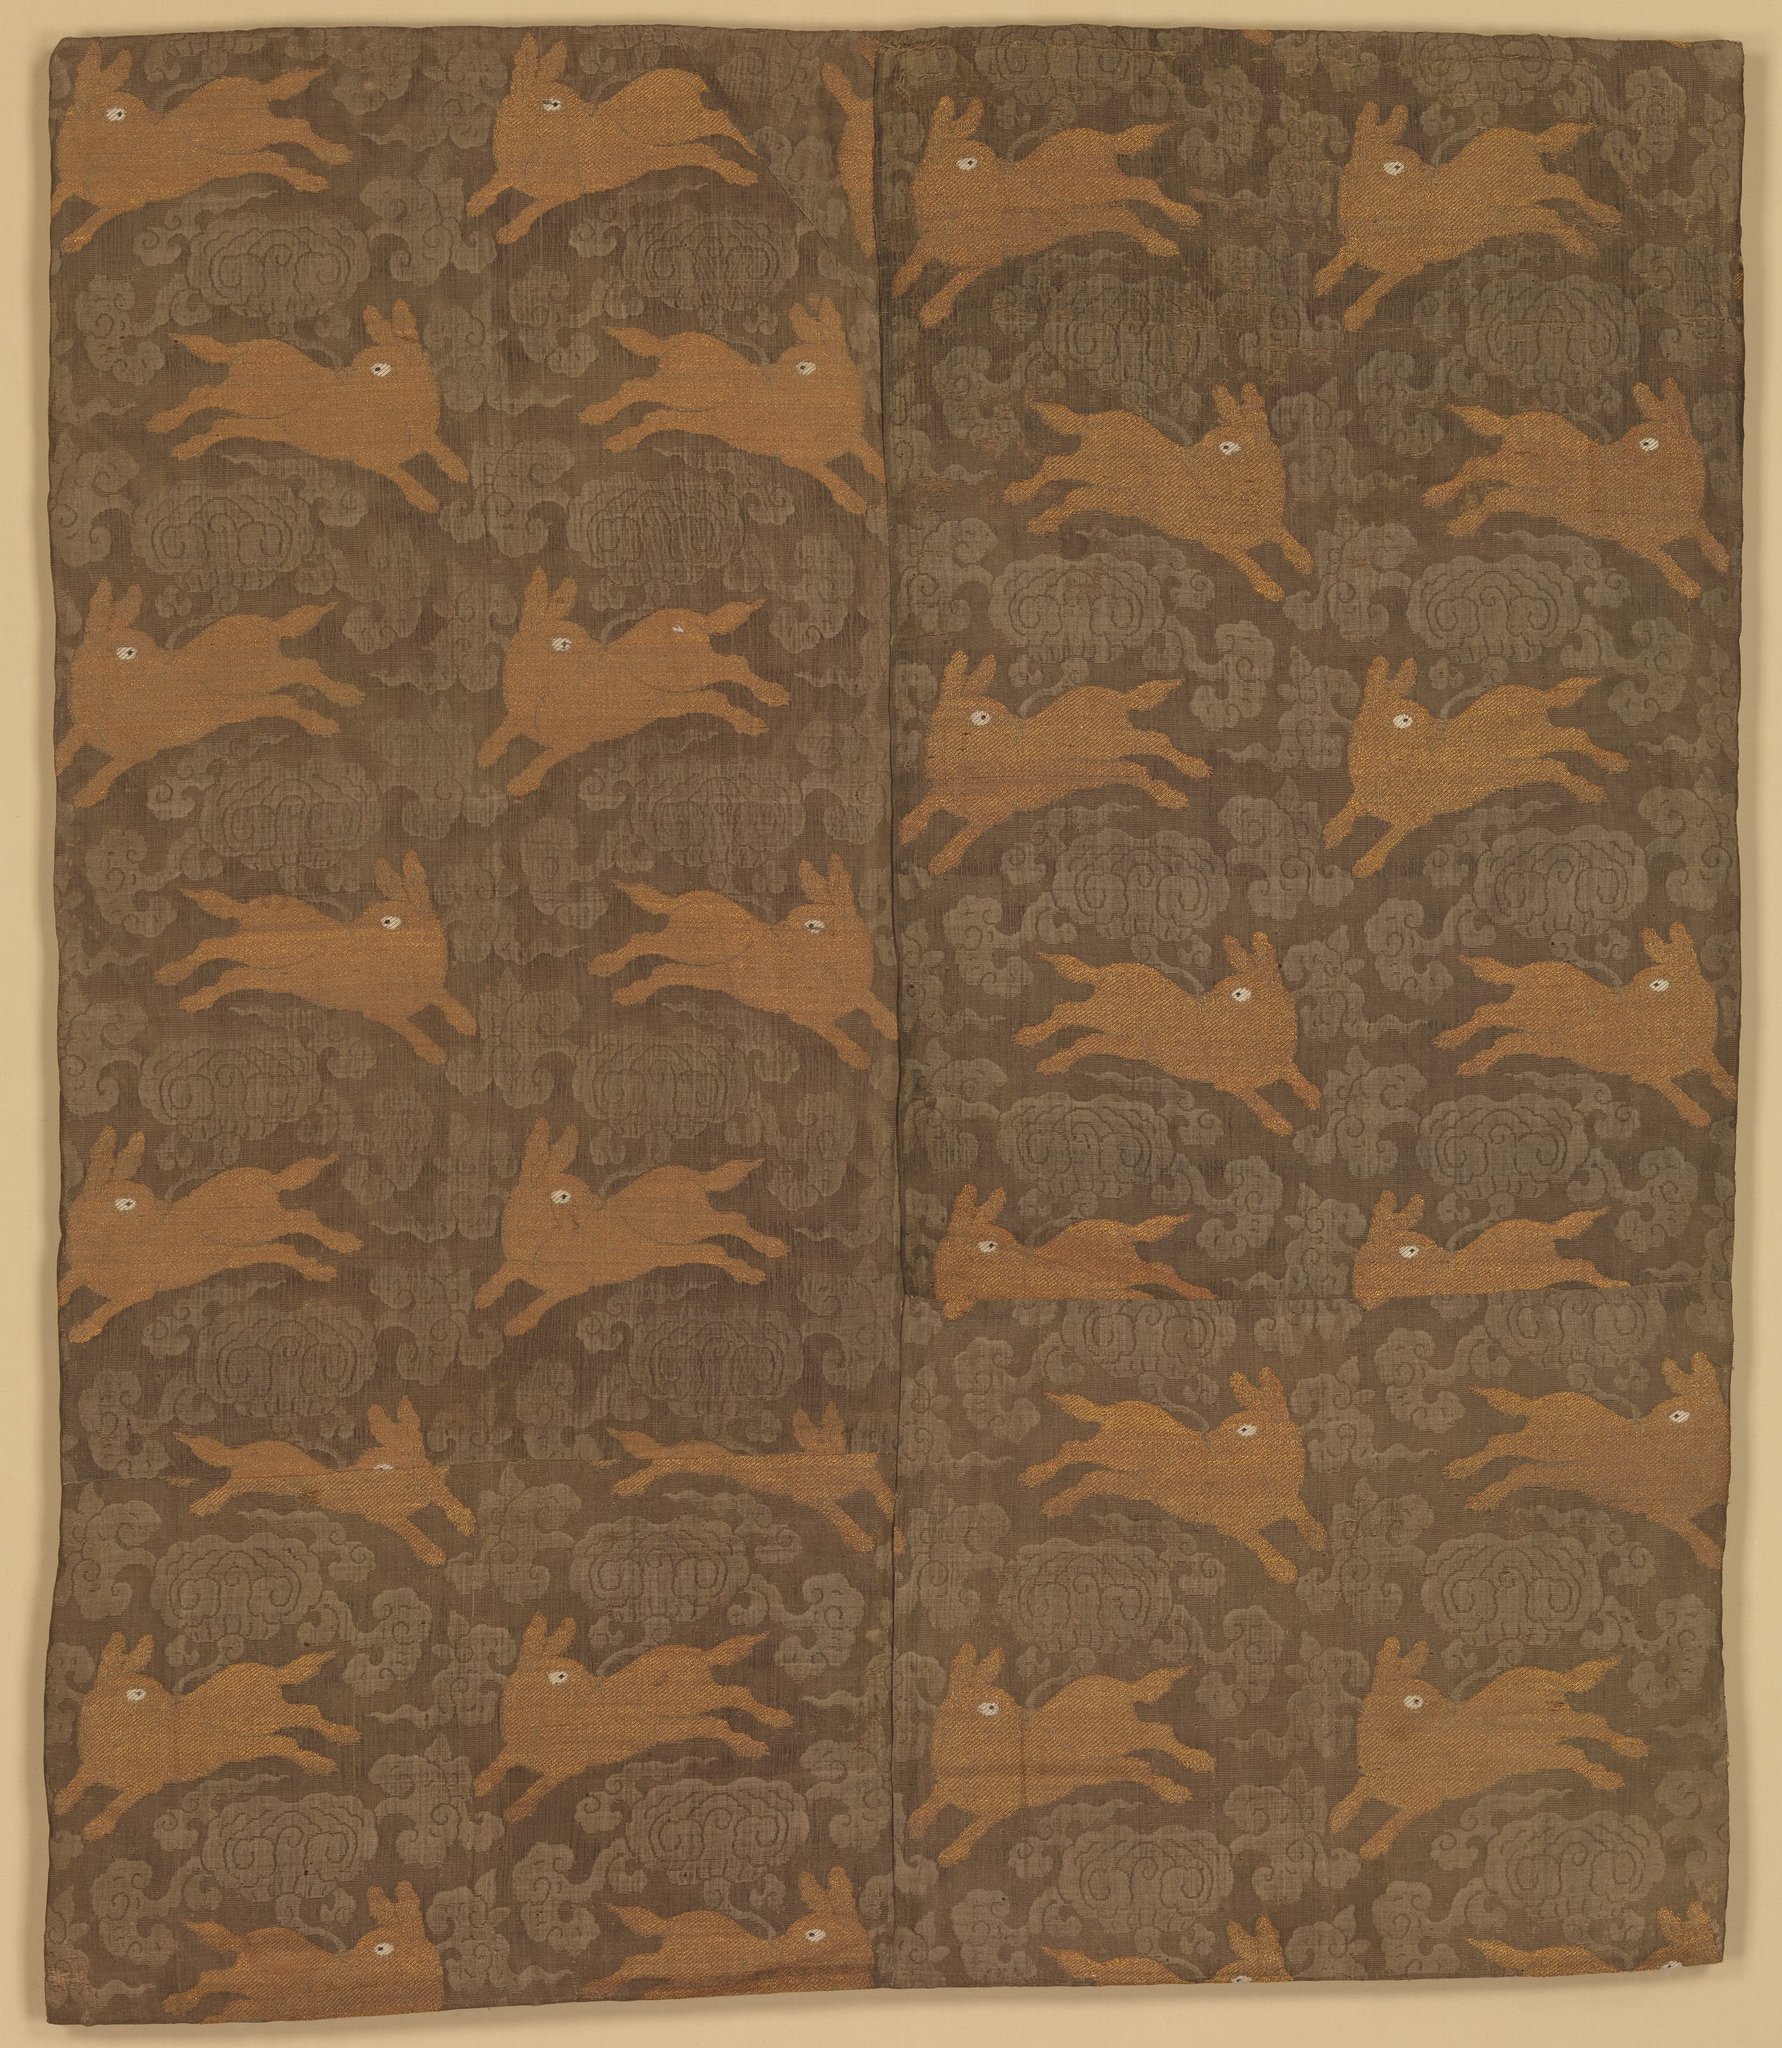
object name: panel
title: Panel with Rabbits amid Clouds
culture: chinese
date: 1567-1633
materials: textile, metal thread, silk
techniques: brocade, patterning, weave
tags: rabbits,clouds